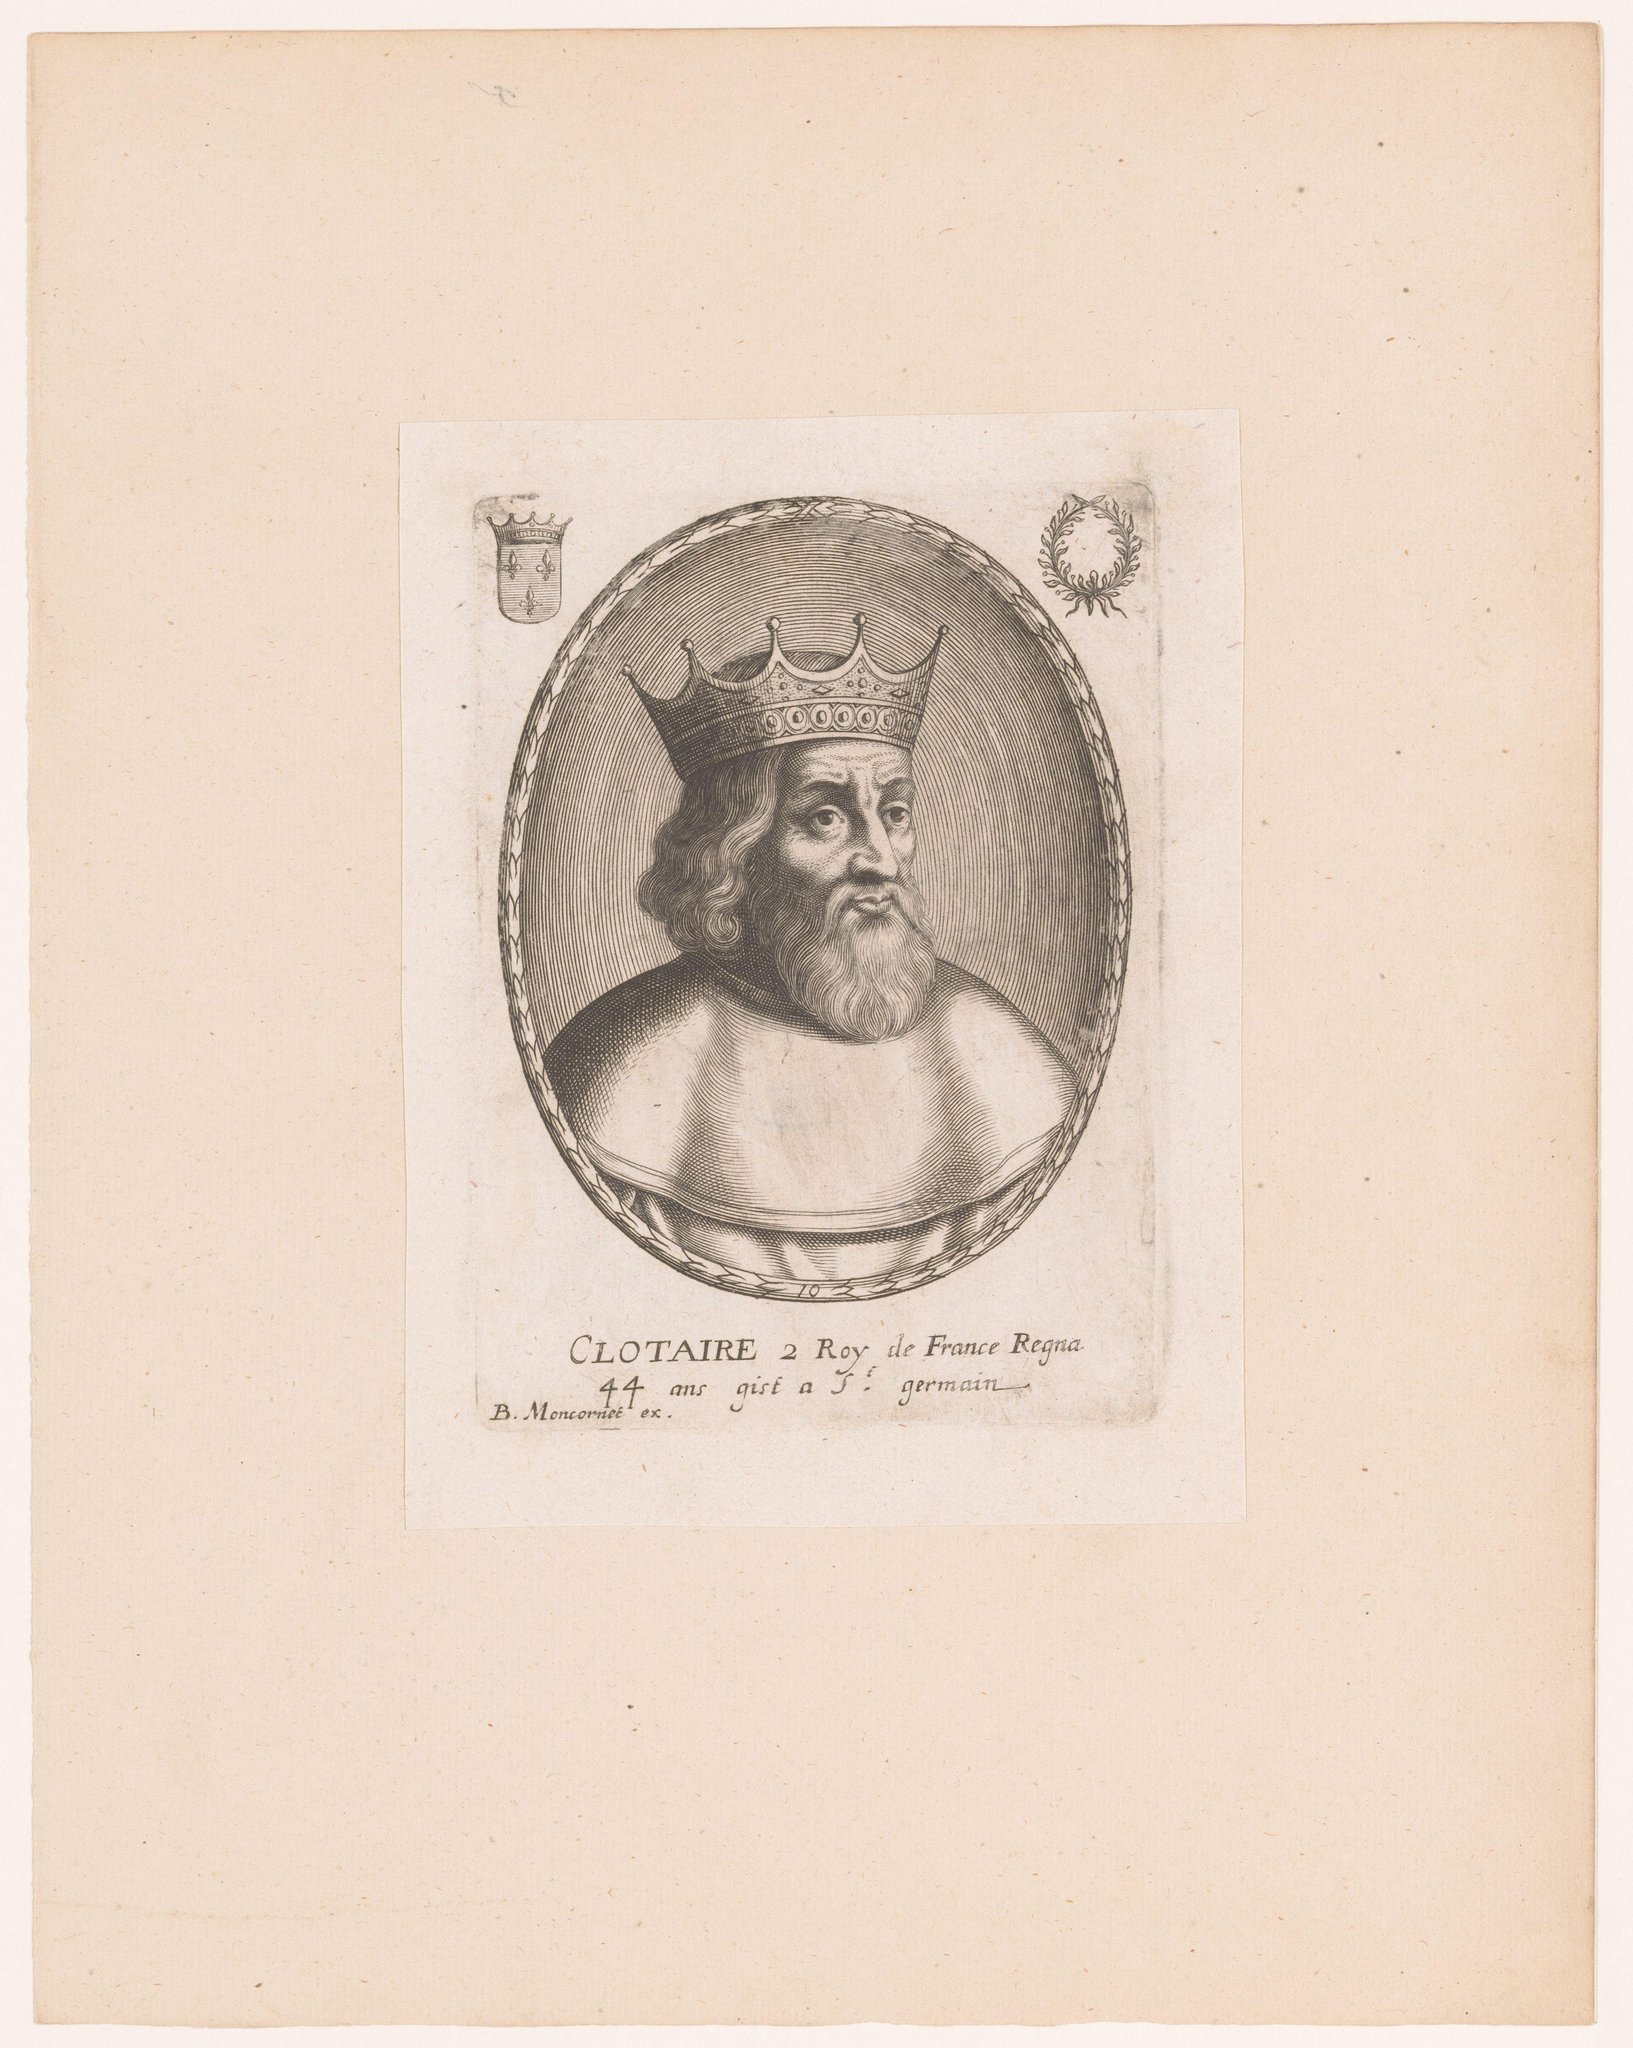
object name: print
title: Portret van Chlotarius II, koning van Frankrijk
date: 1610-1668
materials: paper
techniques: engraving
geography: paris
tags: historical persons, king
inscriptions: collector's mark: Lugt 2228